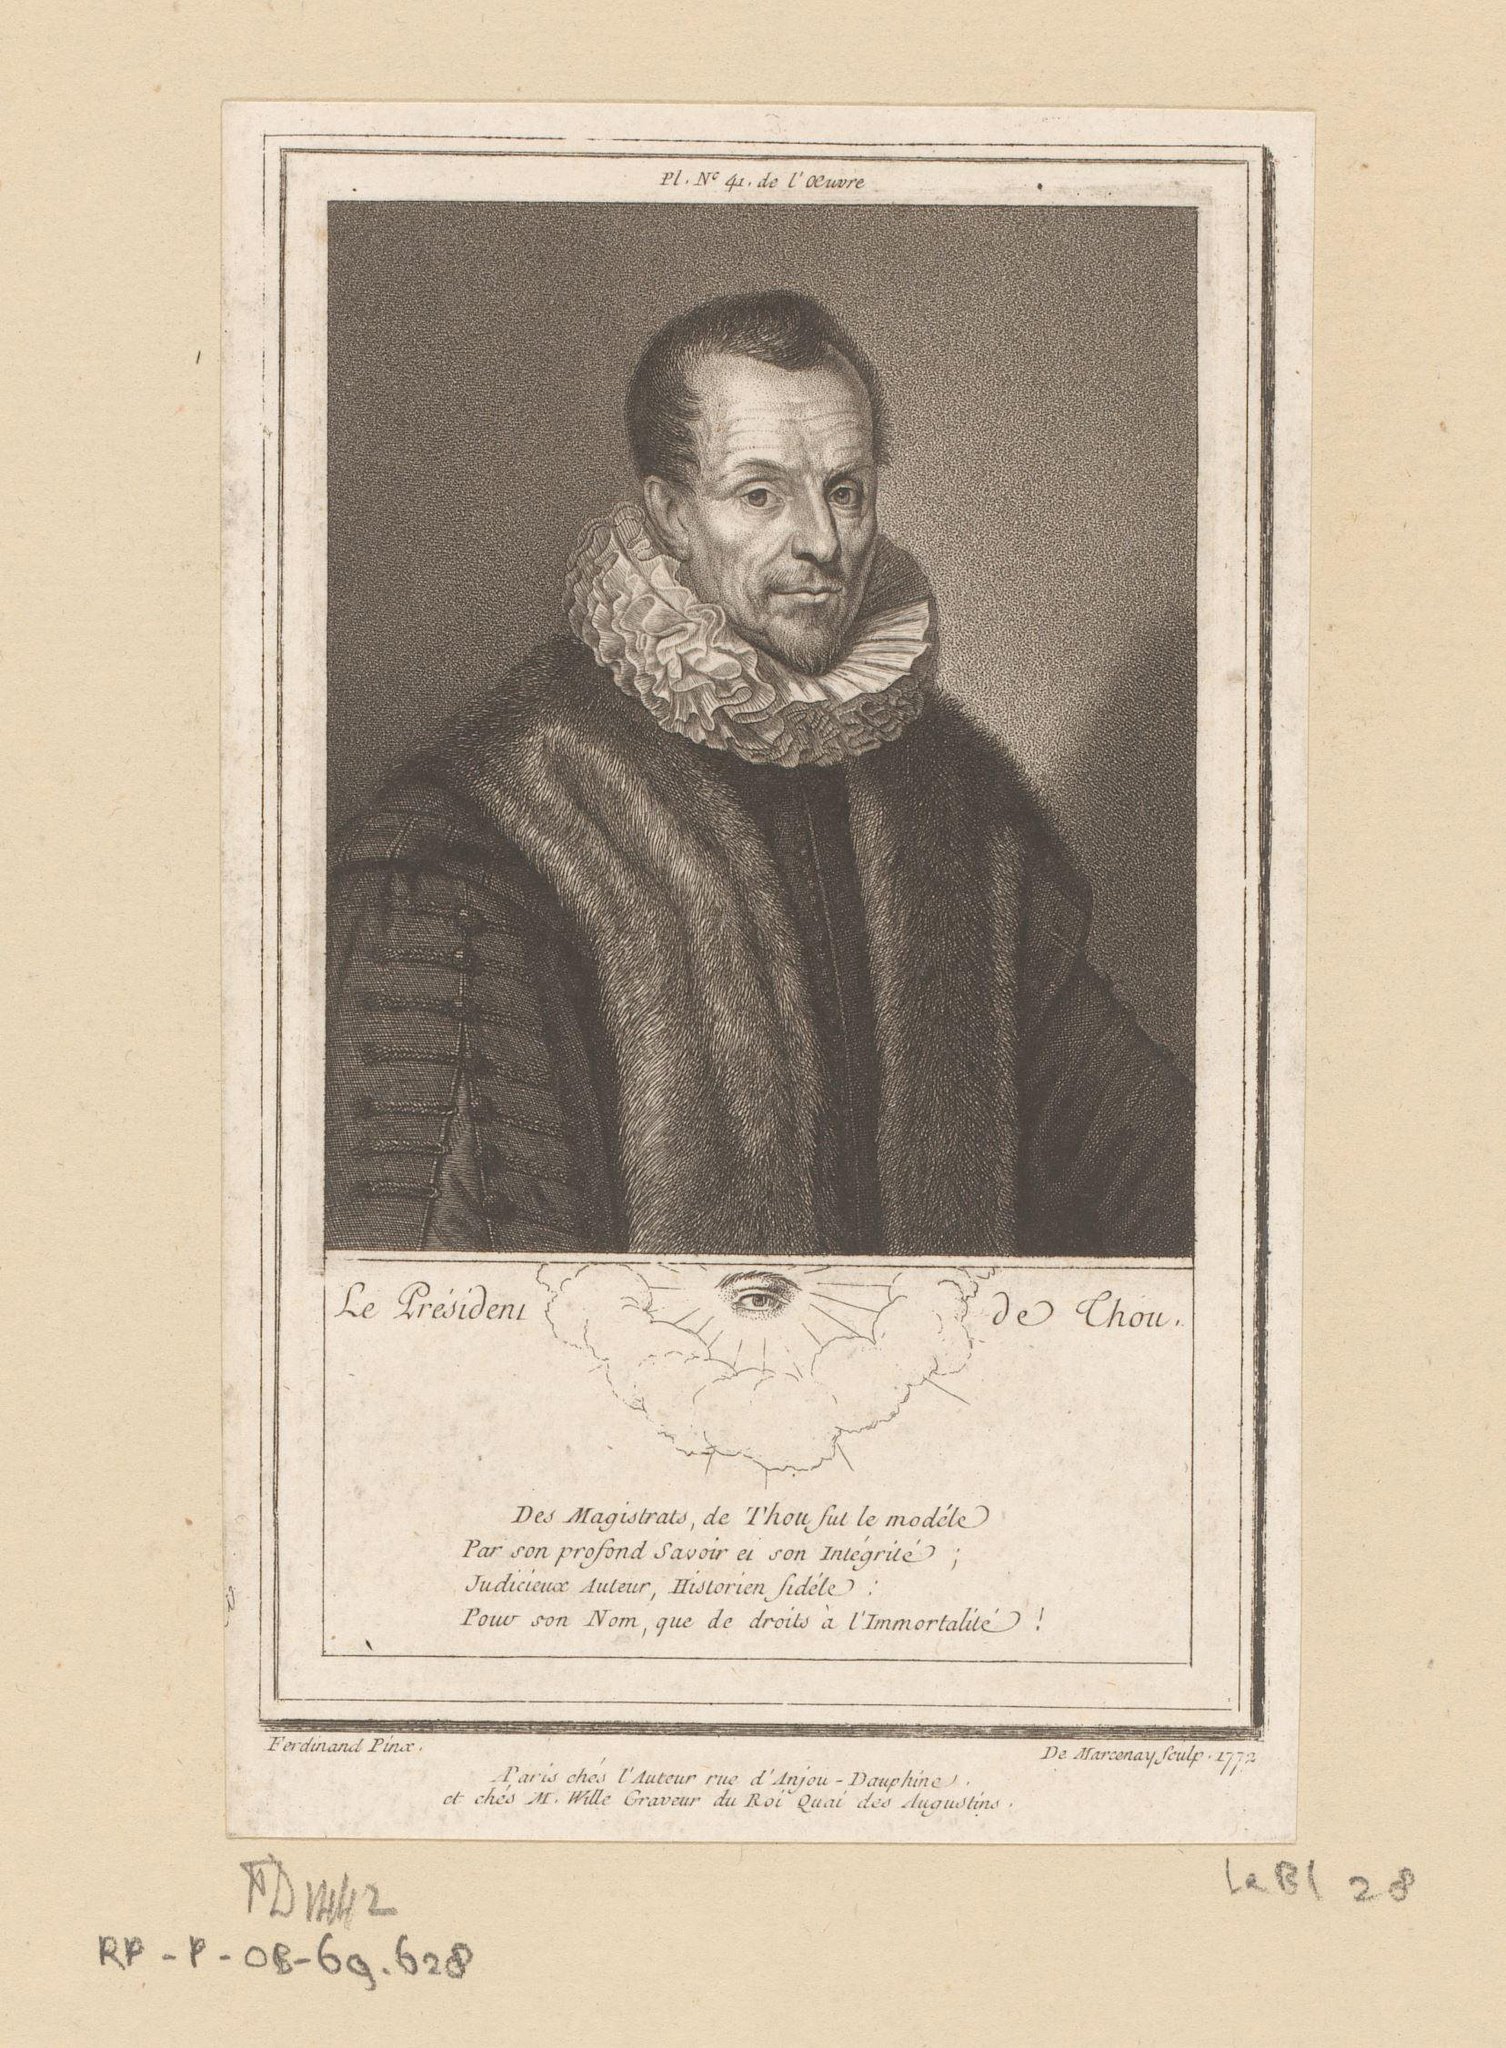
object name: print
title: Portret van Jacques-Auguste de Thou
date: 1772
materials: paper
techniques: etching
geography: paris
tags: paris, politician, historical persons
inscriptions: collector's mark: Lugt 2228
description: Genummerd midden boven: Pl. No. 41. de l'Oeuvre.